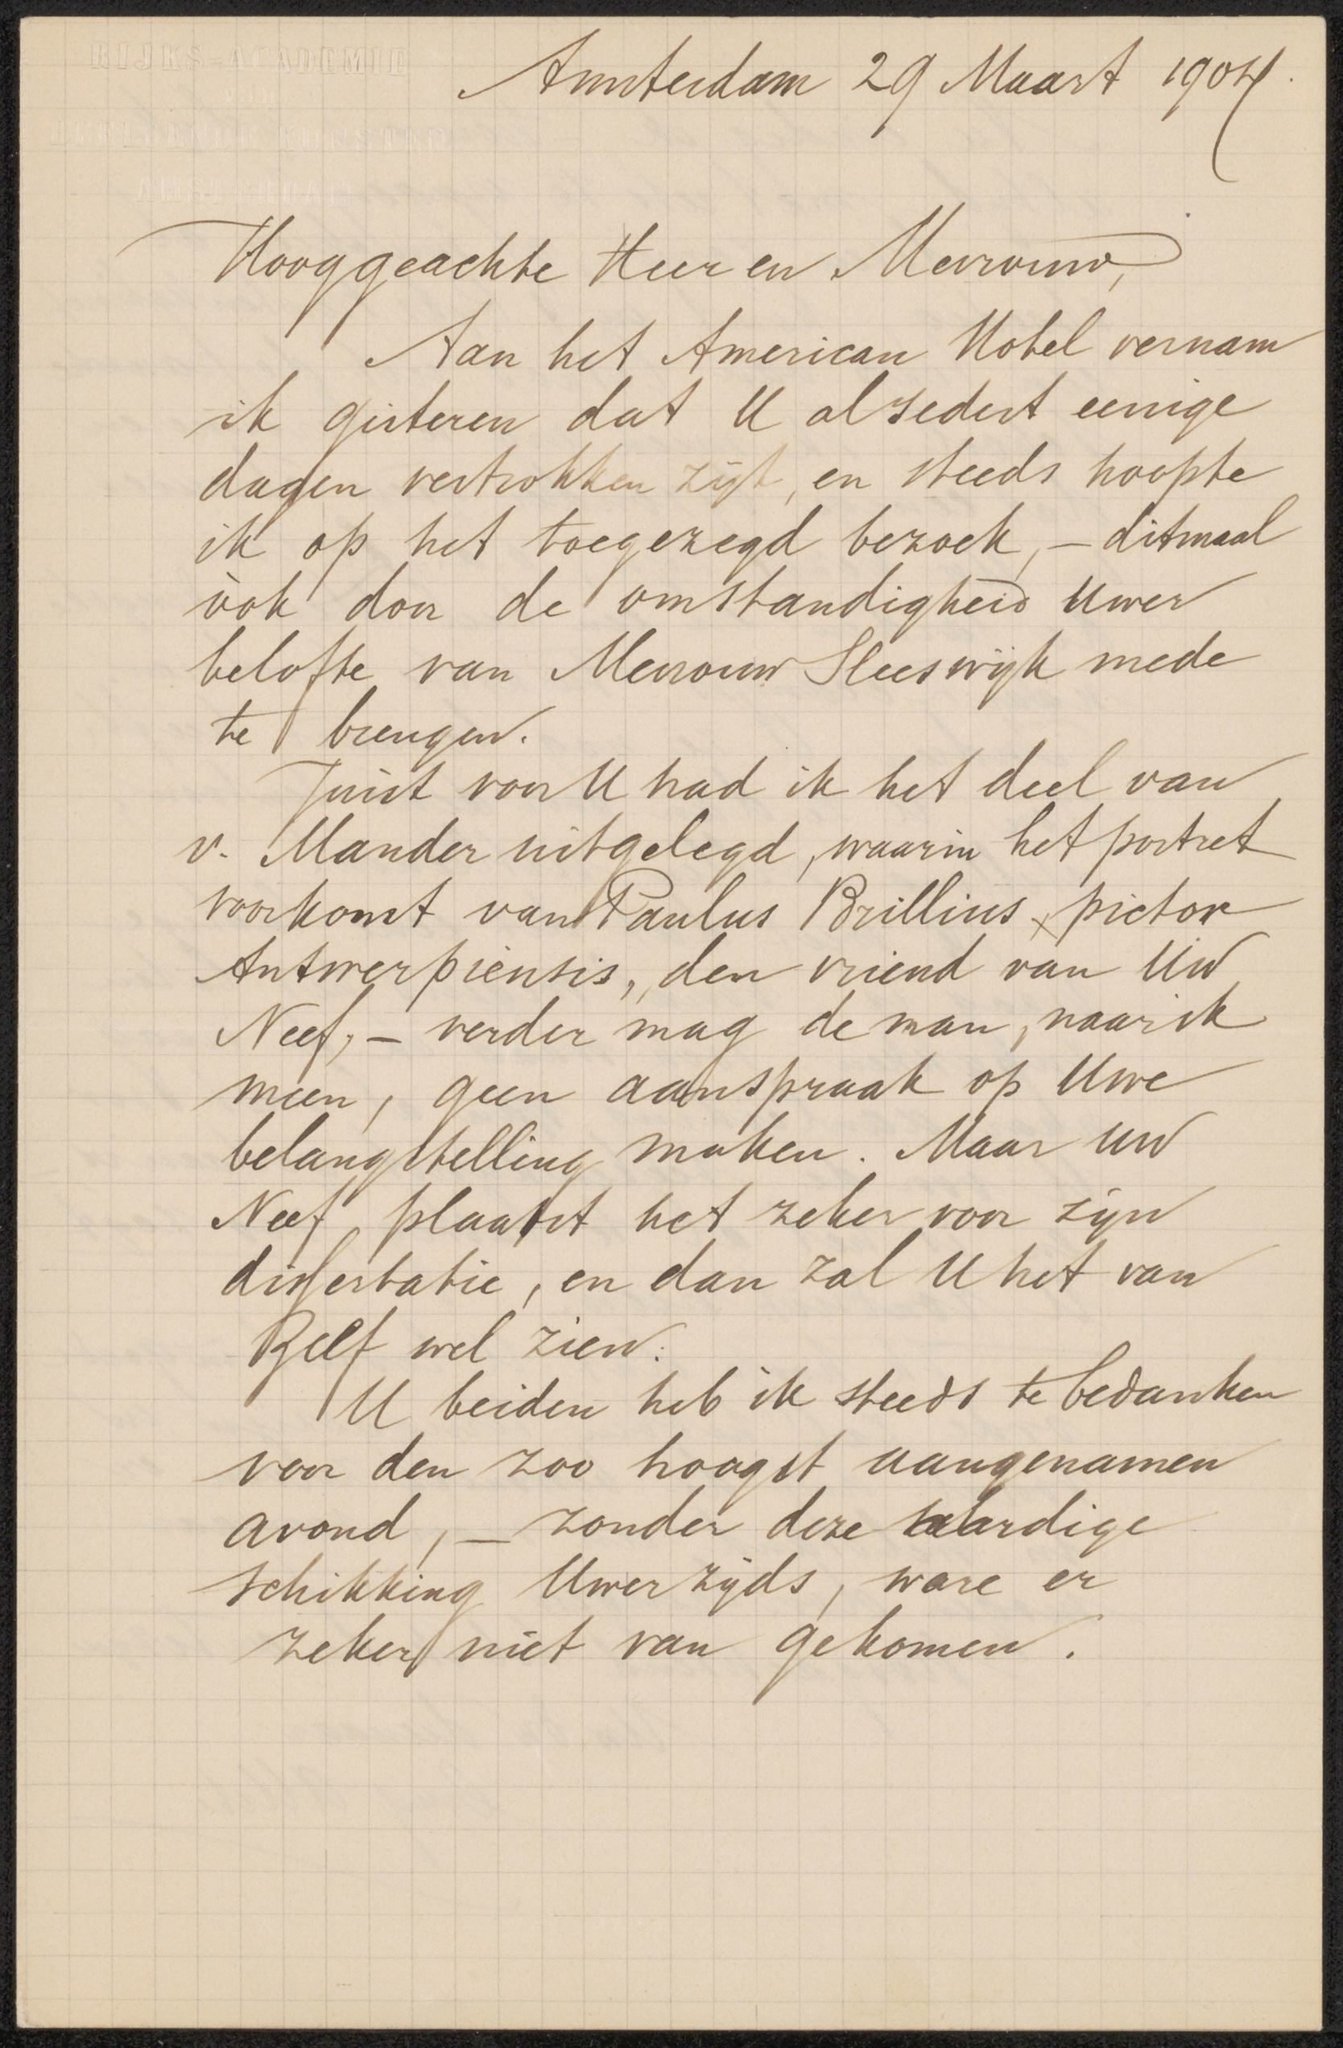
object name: letter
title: Brief aan Max Wilhelm Carl Weber en Anne Antoinette Weber-Van Bosse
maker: august allebé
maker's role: draughtsman, print maker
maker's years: 1838-1927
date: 1904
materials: ink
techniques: pen, writing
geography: amsterdam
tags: painter, print maker, draughtsman, karel van mander (i), print room, amsterdam, anne antoinette weber-van bosse, antwerp, rome, paul bril, alexandre-gabriel decamps, the graphic arts, exhibition ~ art, historical persons (portraits and scenes from the life)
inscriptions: name: ‘RIJKS-ACADEMIE/ VAN/ BEELDENDE KUNSTEN/ AMSTERDAM’